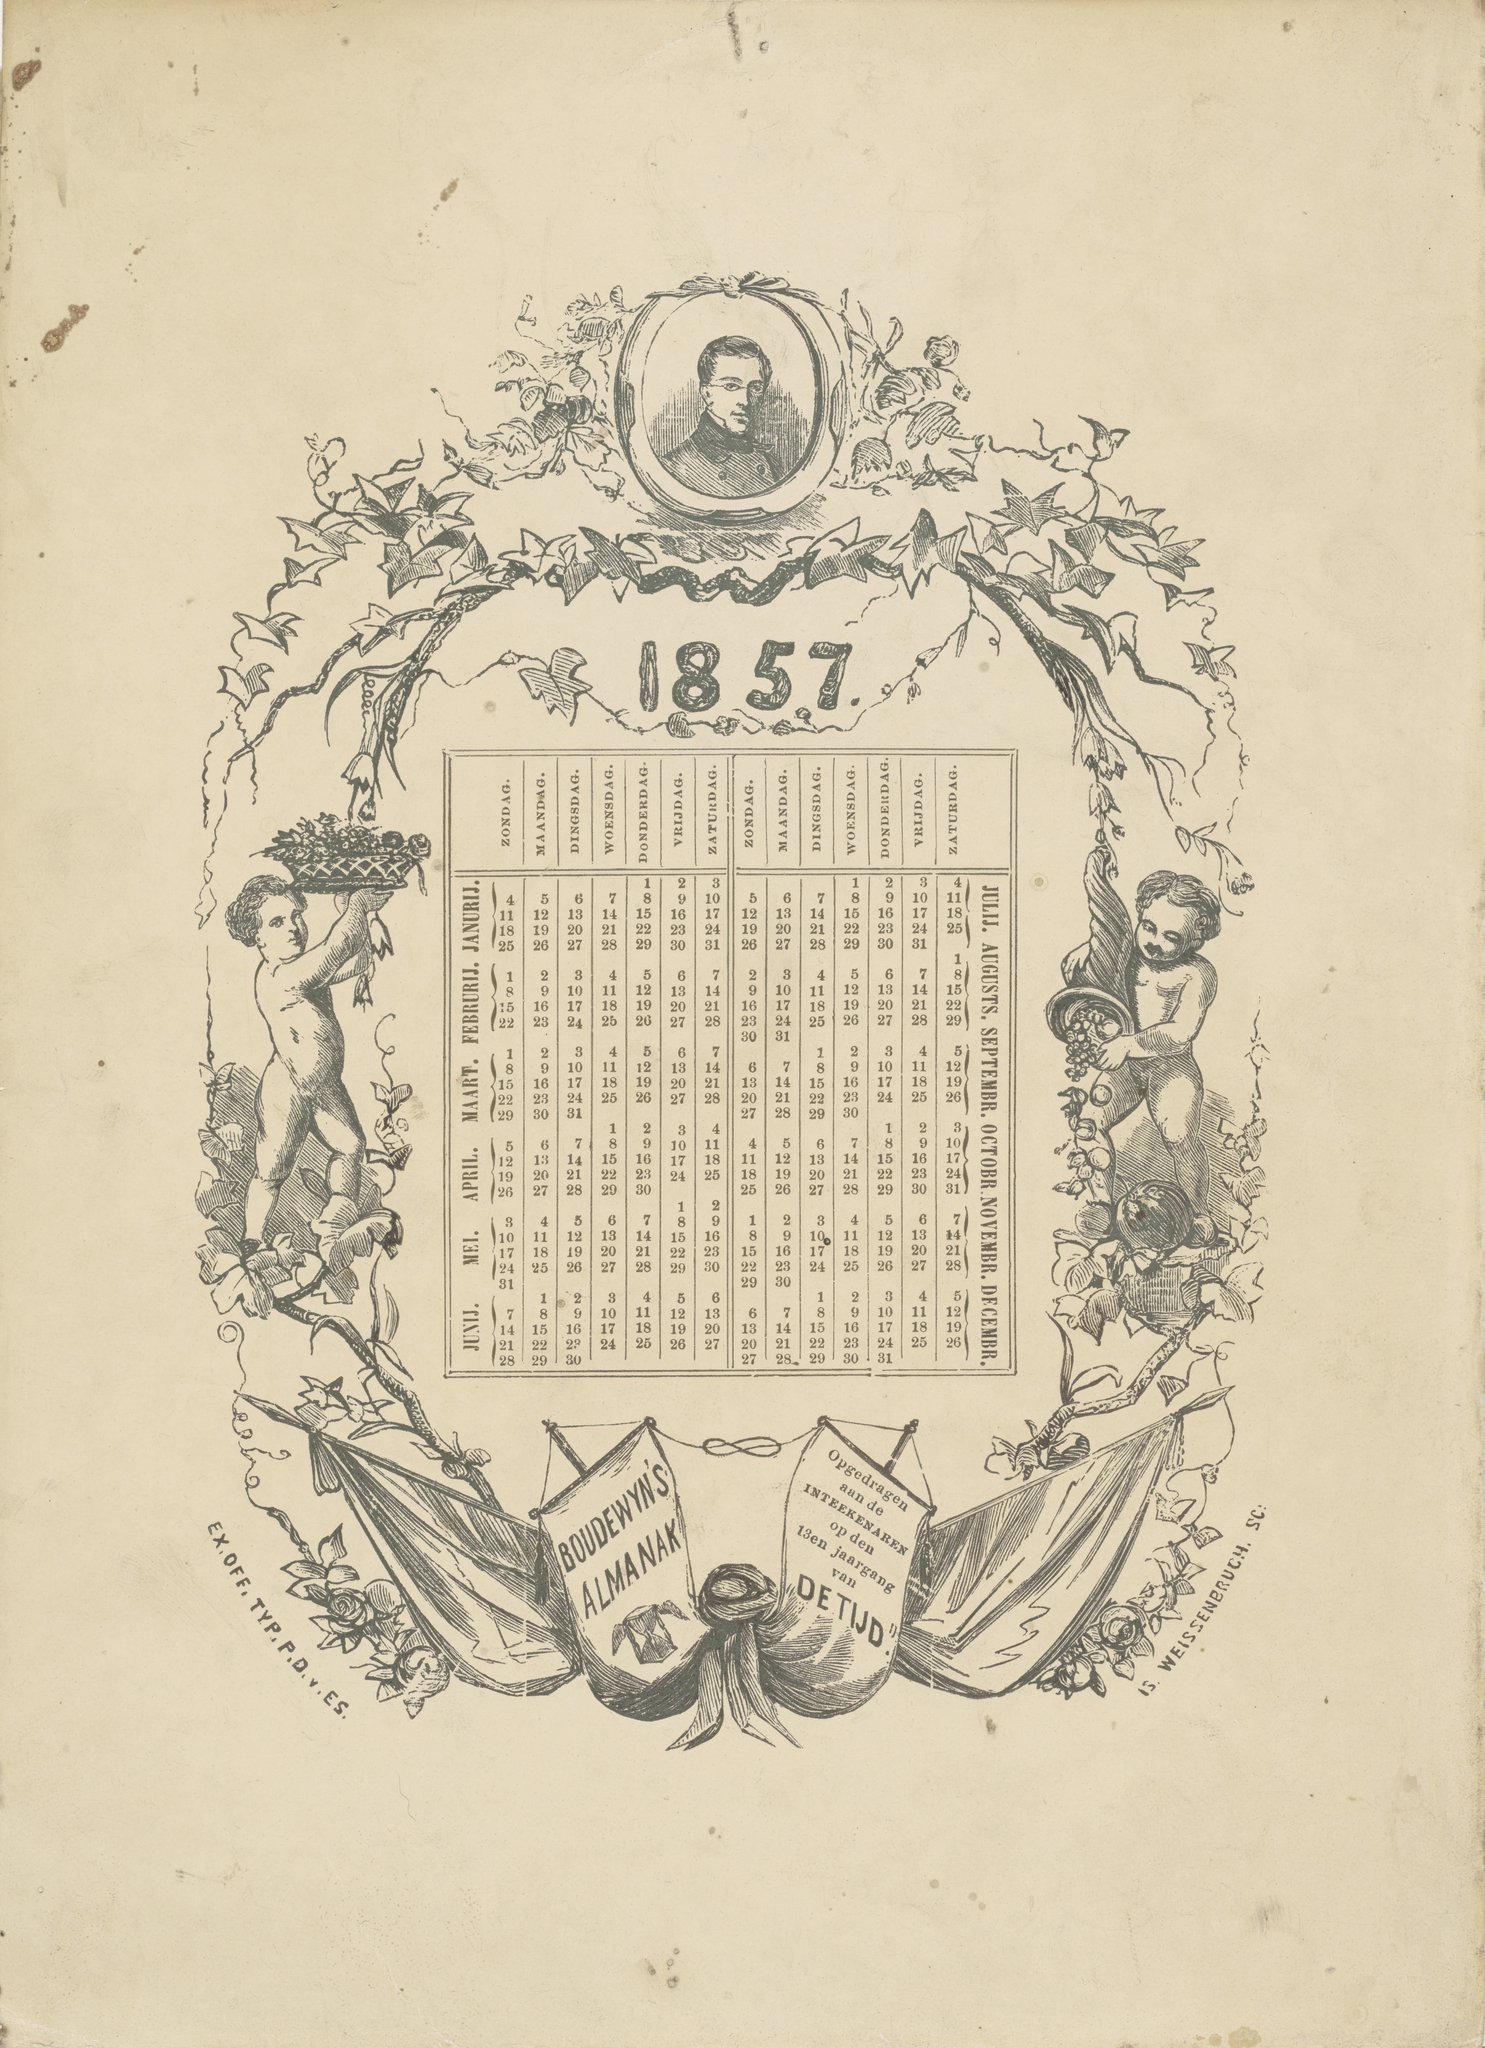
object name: print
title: Kalender voor 1857 in een geornamenteerde omlijsting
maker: isaac weissenbruch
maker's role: print maker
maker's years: 1826-1912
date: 1857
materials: paper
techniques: engraving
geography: netherlands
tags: plants (in general), 'cornucopia', horn of plenty, calendar, almanac, cupids: 'amores', 'amoretti', 'putti'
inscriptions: collector's mark: Lugt 2228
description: De twaalf maanden van het jaar met de dagen van de week. Midden boven een portret van een man met een bril. Daar omheen bloemen, planten en een aantal putti met de hoorn des overvloeds.